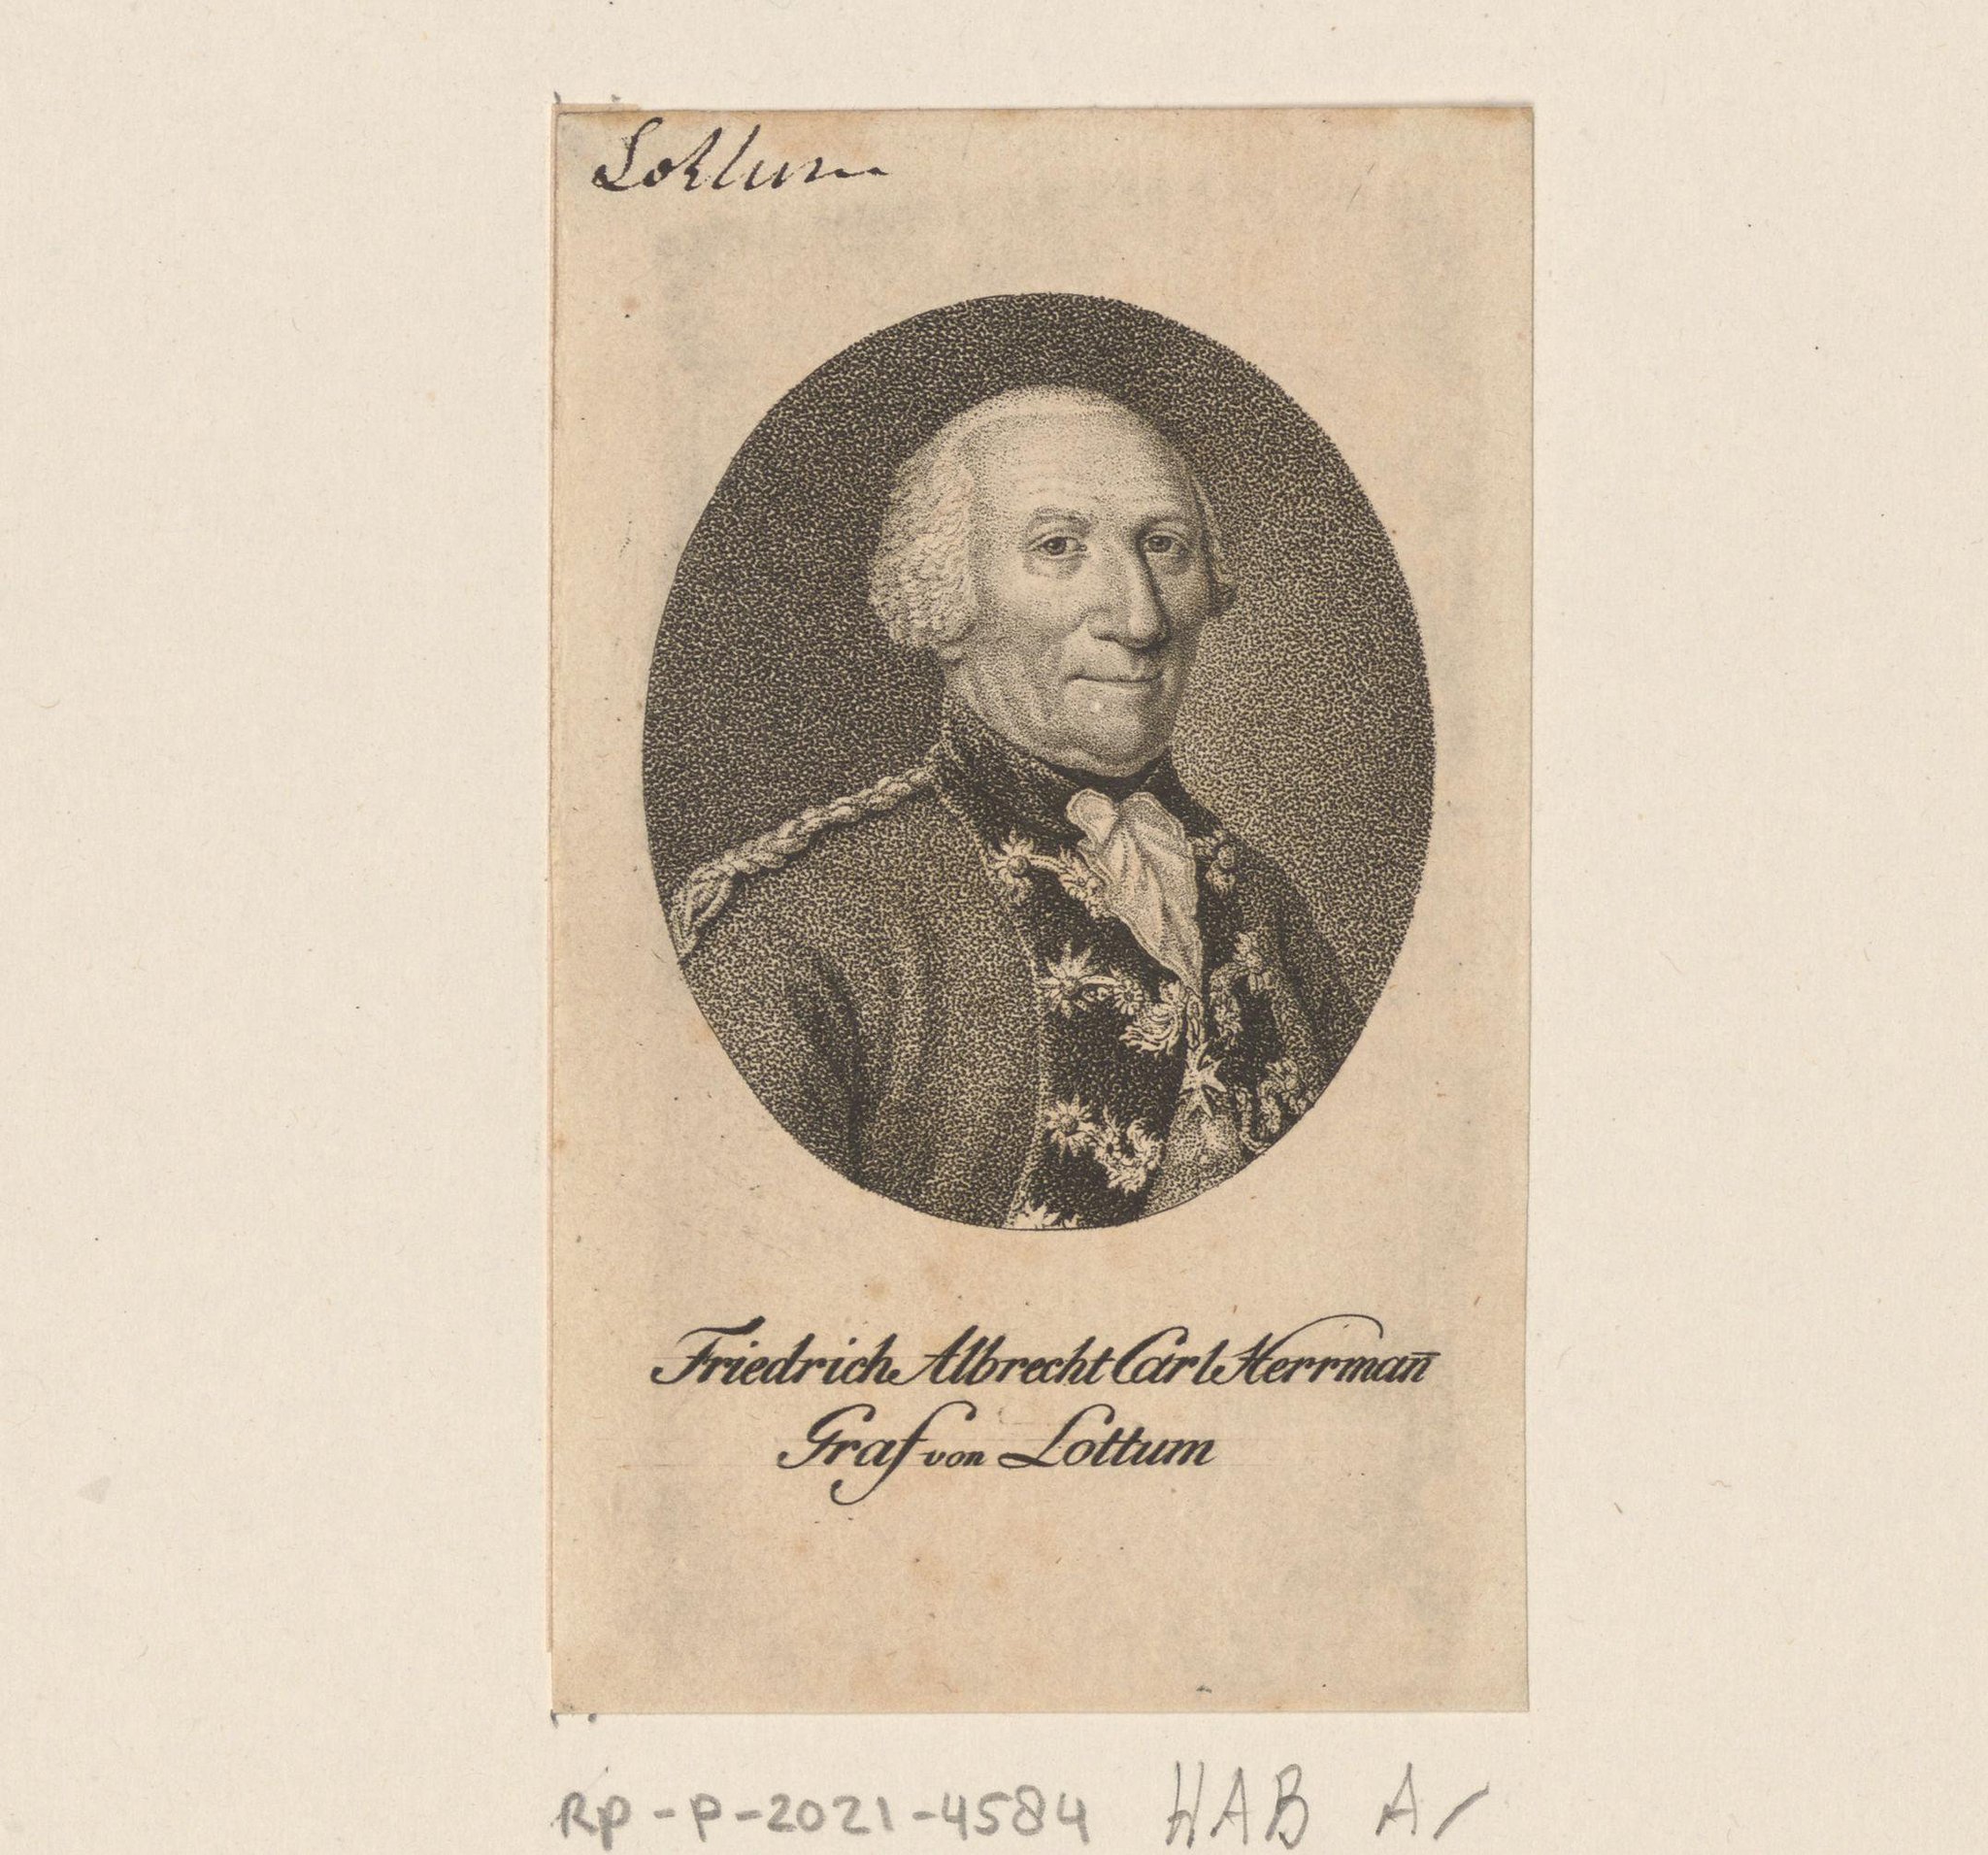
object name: print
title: Portret van Friedrich Albrecht Carl Hermann von Wylich und Lottum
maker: Anonymous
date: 1760-1799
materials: paper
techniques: stippling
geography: germany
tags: berlin, commander-in-chief, general, marshal, historical persons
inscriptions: inscription: ‘Lottum’